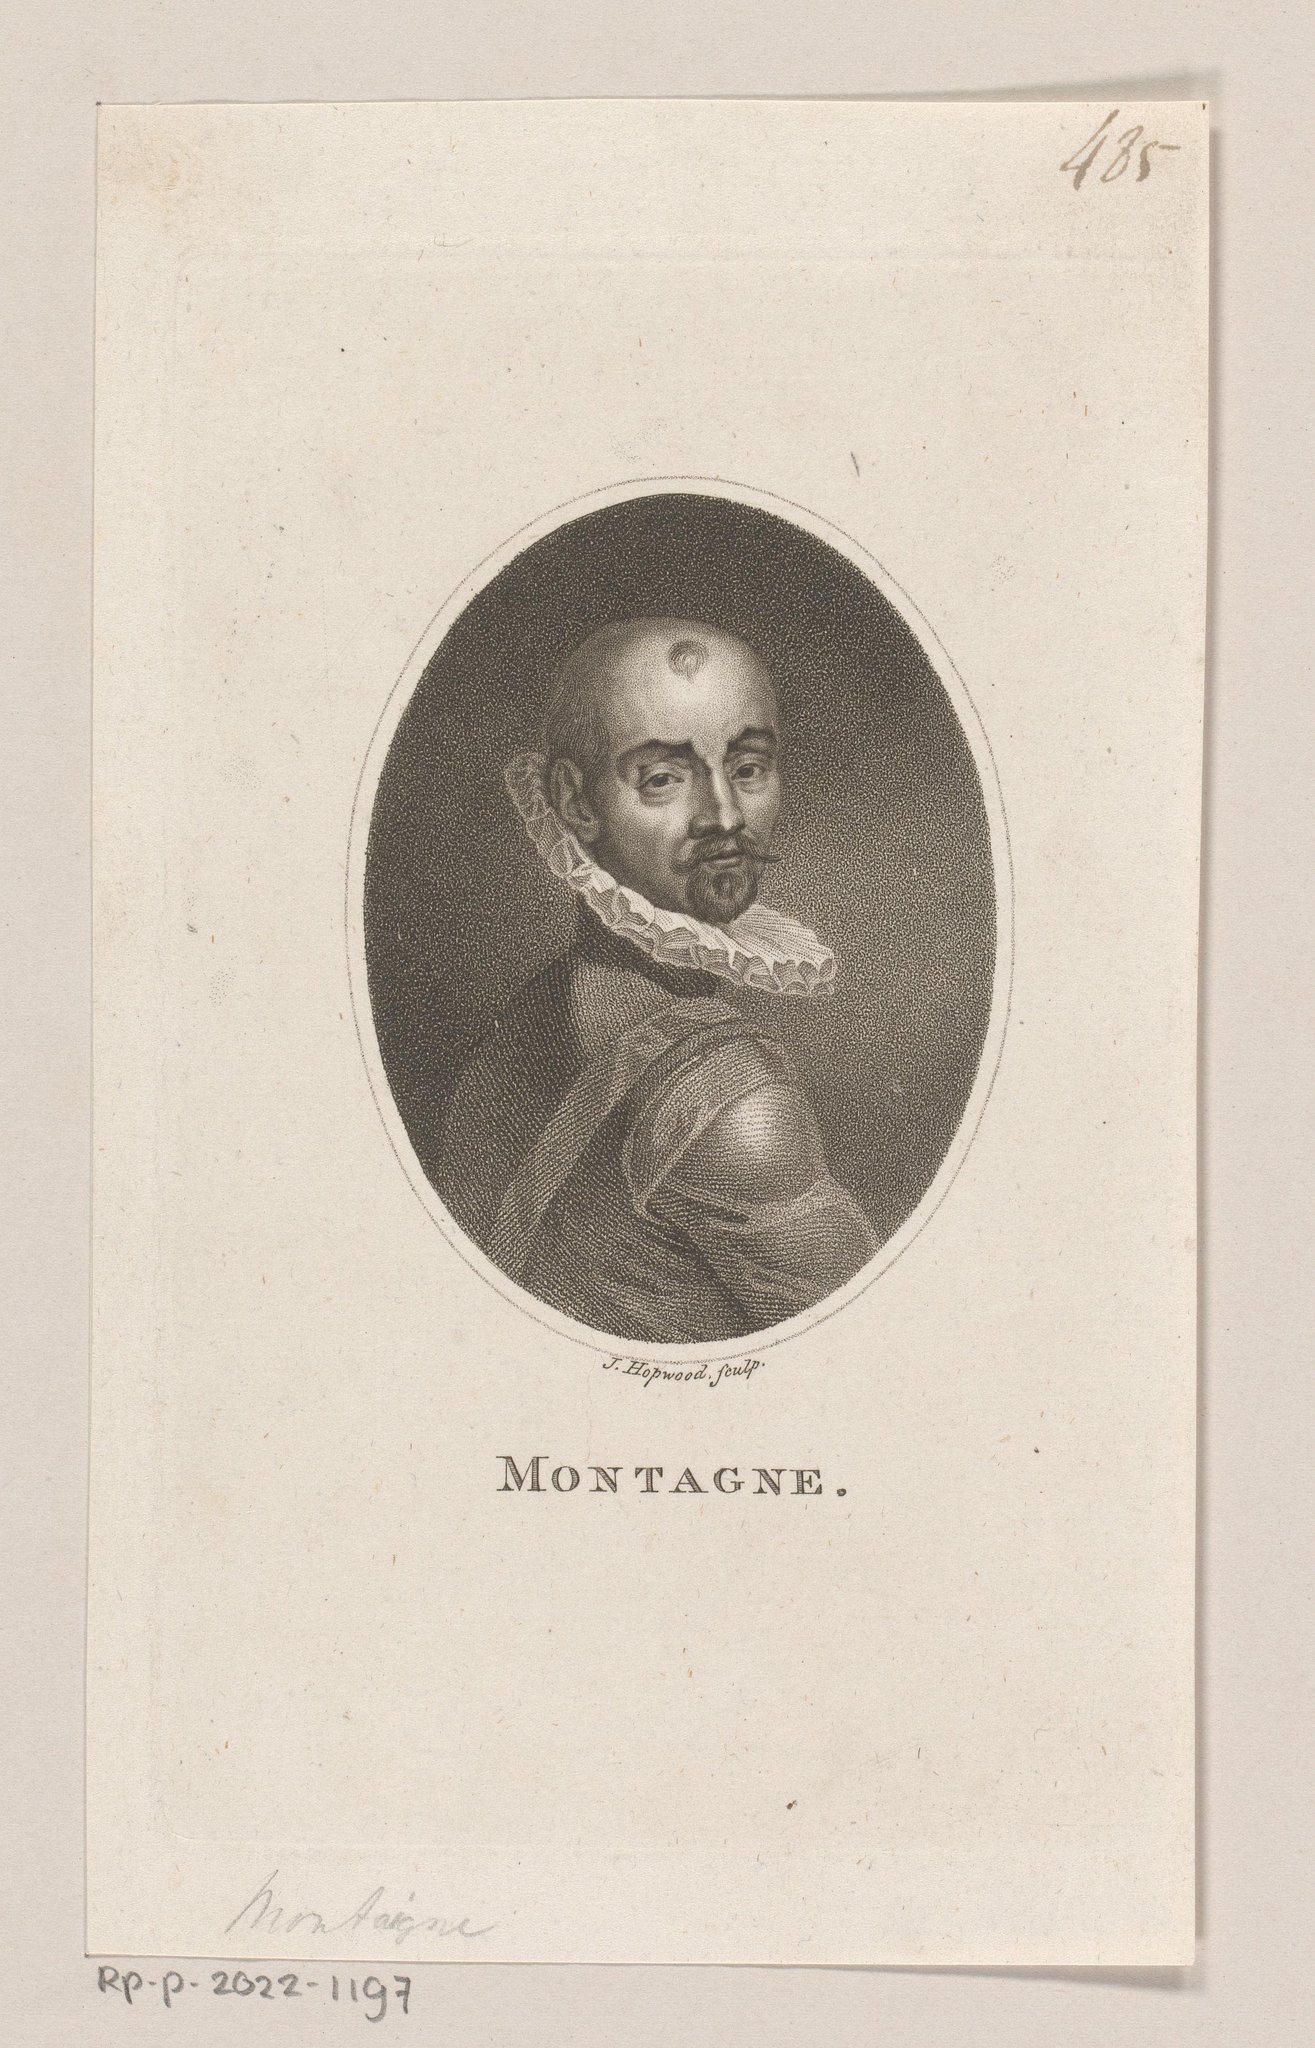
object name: print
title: Montagne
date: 1762-1855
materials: paper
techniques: etching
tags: michel eyquem de montaigne, scholar, philosopher, historical persons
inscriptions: number: ‘485’